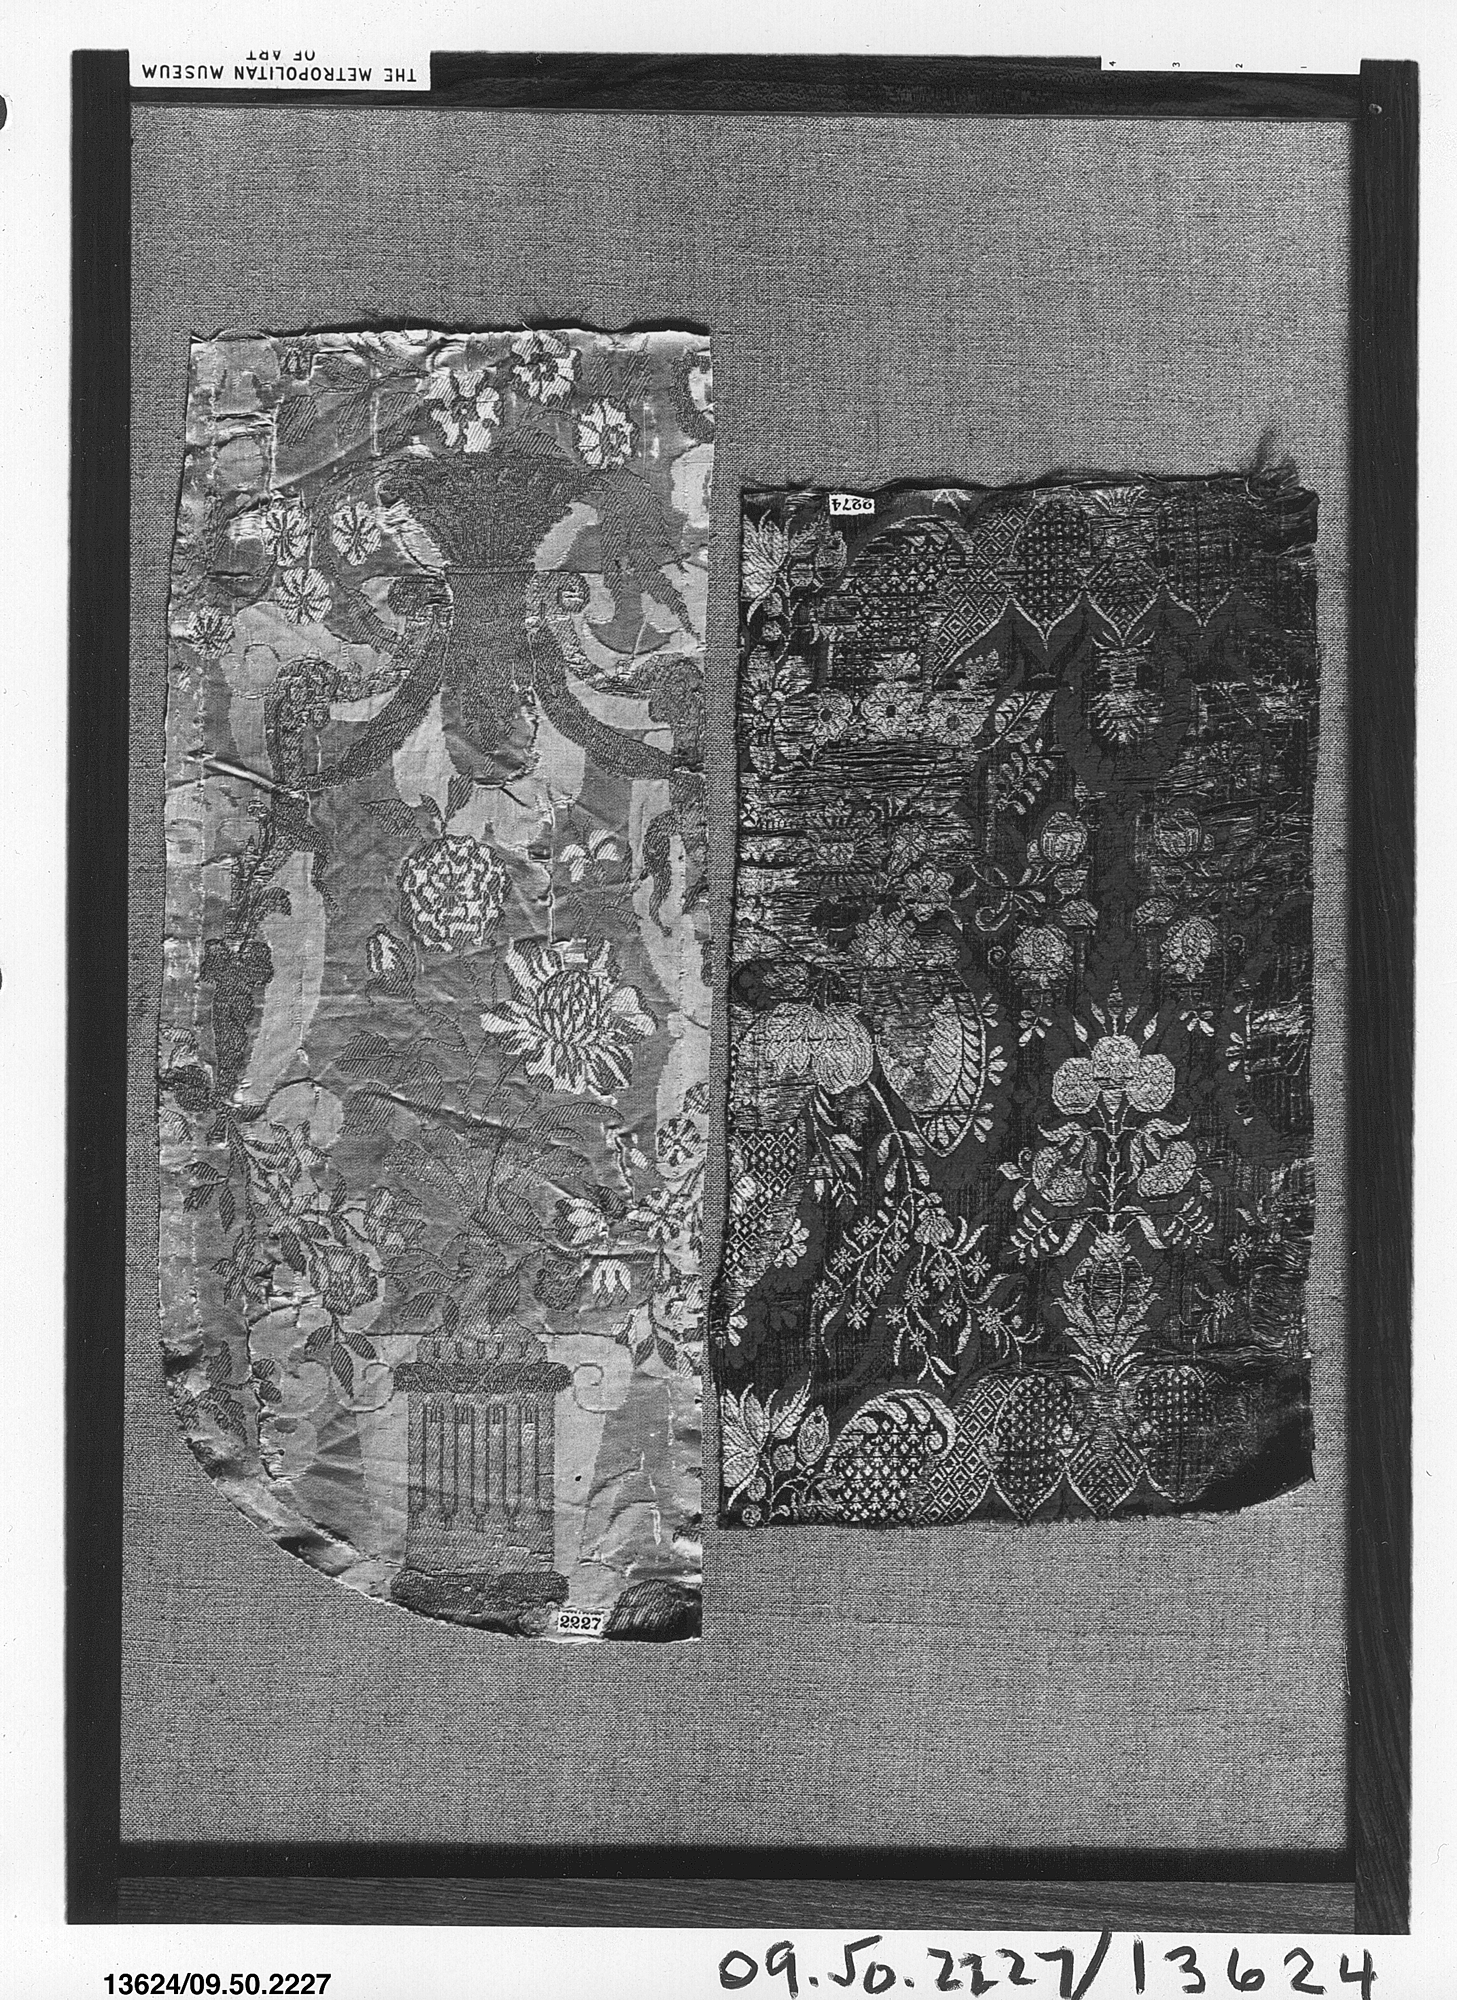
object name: piece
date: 1701-1750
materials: metal thread, silk